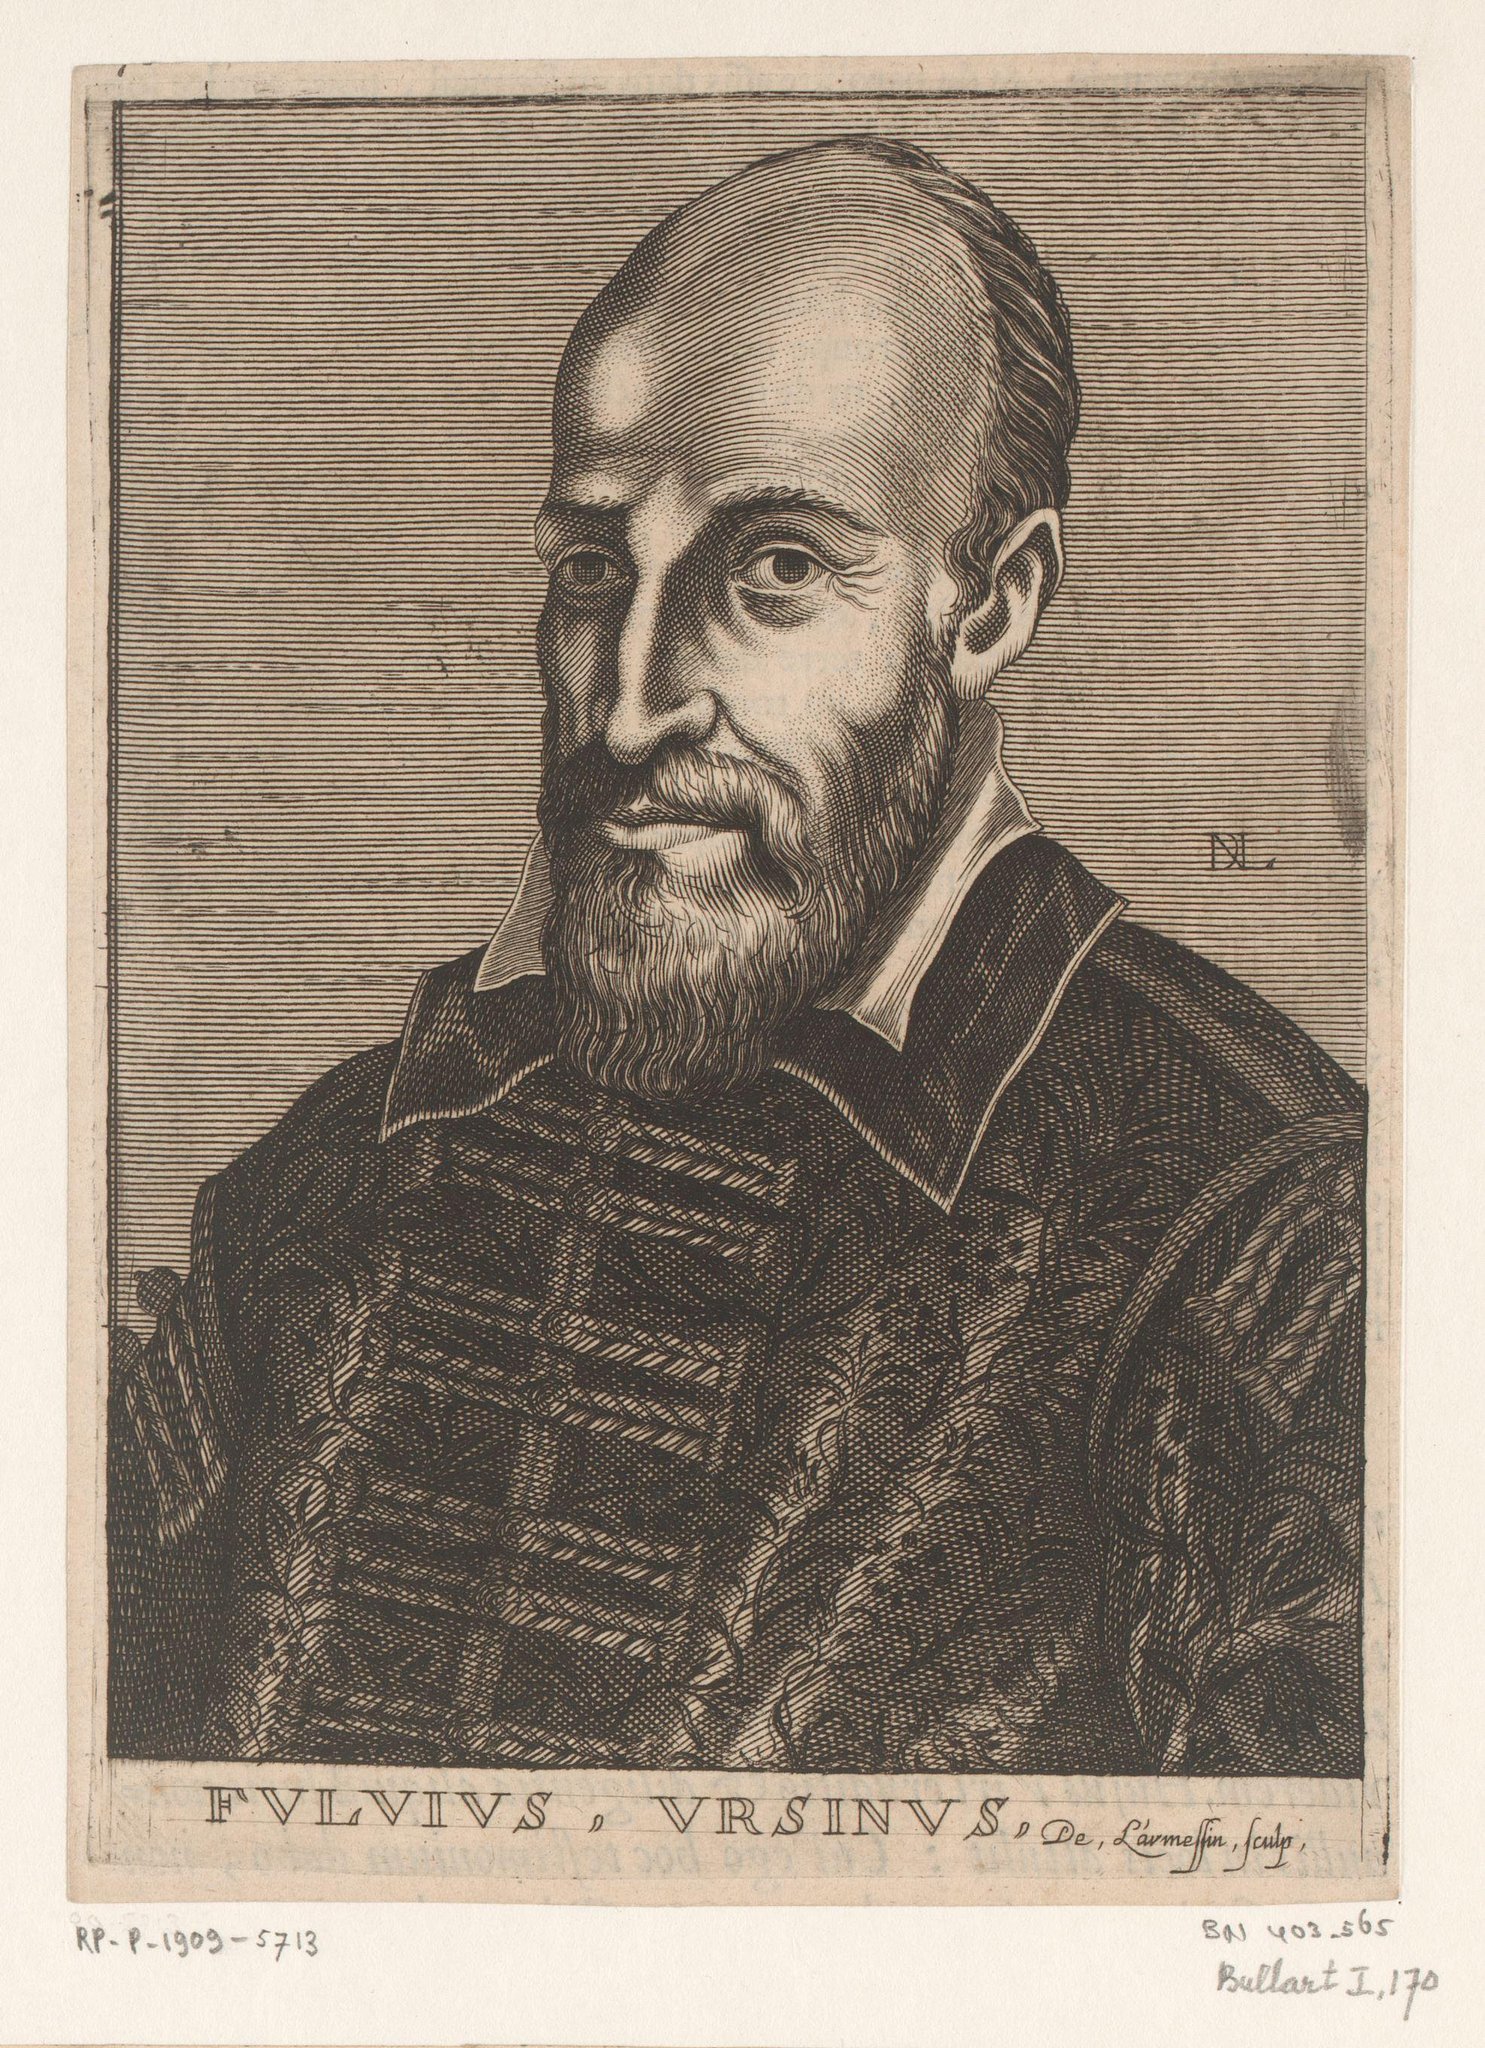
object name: print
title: Portret van Fulvio Orsini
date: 1682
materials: paper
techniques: engraving, letterpress printing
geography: brussels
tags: rome, scholar, philosopher, historical persons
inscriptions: collector's mark: Lugt 2228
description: Prent gebruikt voor: Bullart, Isaac. Académie des Sciences et Arts contenant les vies et éloges his. des hommes illustres qui ont excellé en ces professions depuis environ quatre siècles. Brussel: François Foppens, 1682. Het boek werd in 1682 eveneens in Amsterdam uitgegeven door de erfgenamen van Daniel Elzevier. Ieder portret betreft een illustratie bij de biografie van een kunstenaar of geleerde. De meeste portretten werden door Nicolas de Larmessin vervaardigd (162), 93 door De Boulonois en een derde door ongeïdentificeerde prentmakers. Dit betreft een illustratie op p. 171, deel I.